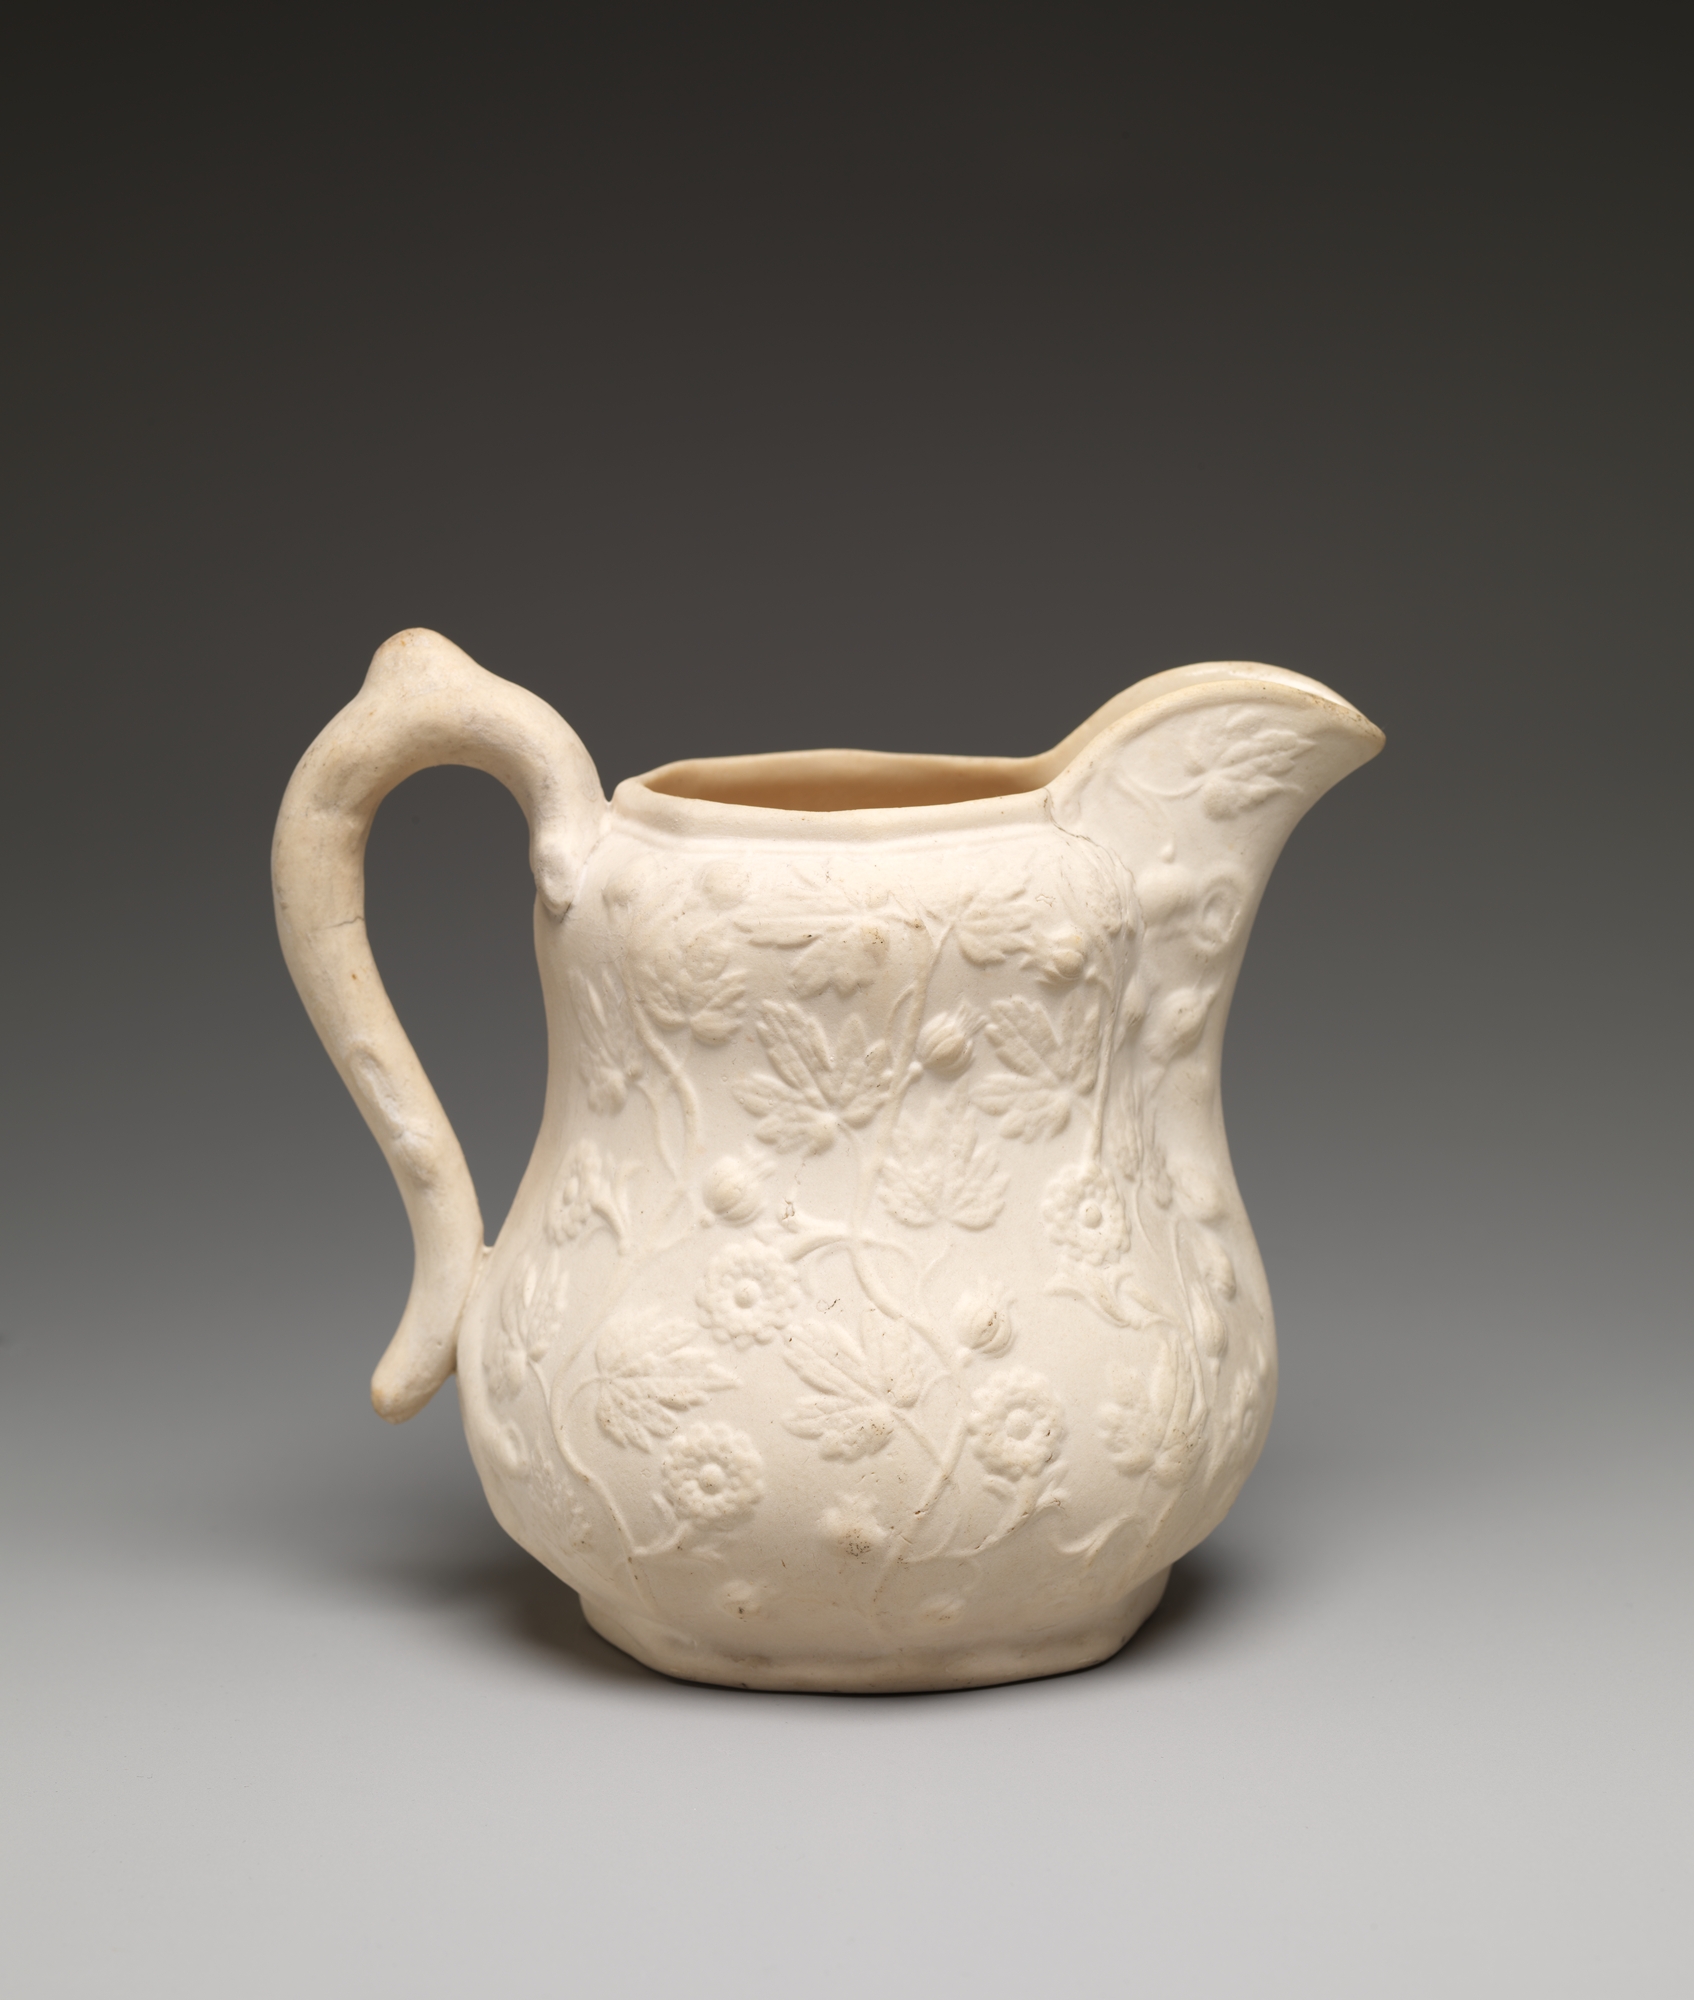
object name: pitcher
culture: american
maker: fenton's works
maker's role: maker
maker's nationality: american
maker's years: 1847-1848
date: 1847-1848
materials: porcelain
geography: united states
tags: flowers